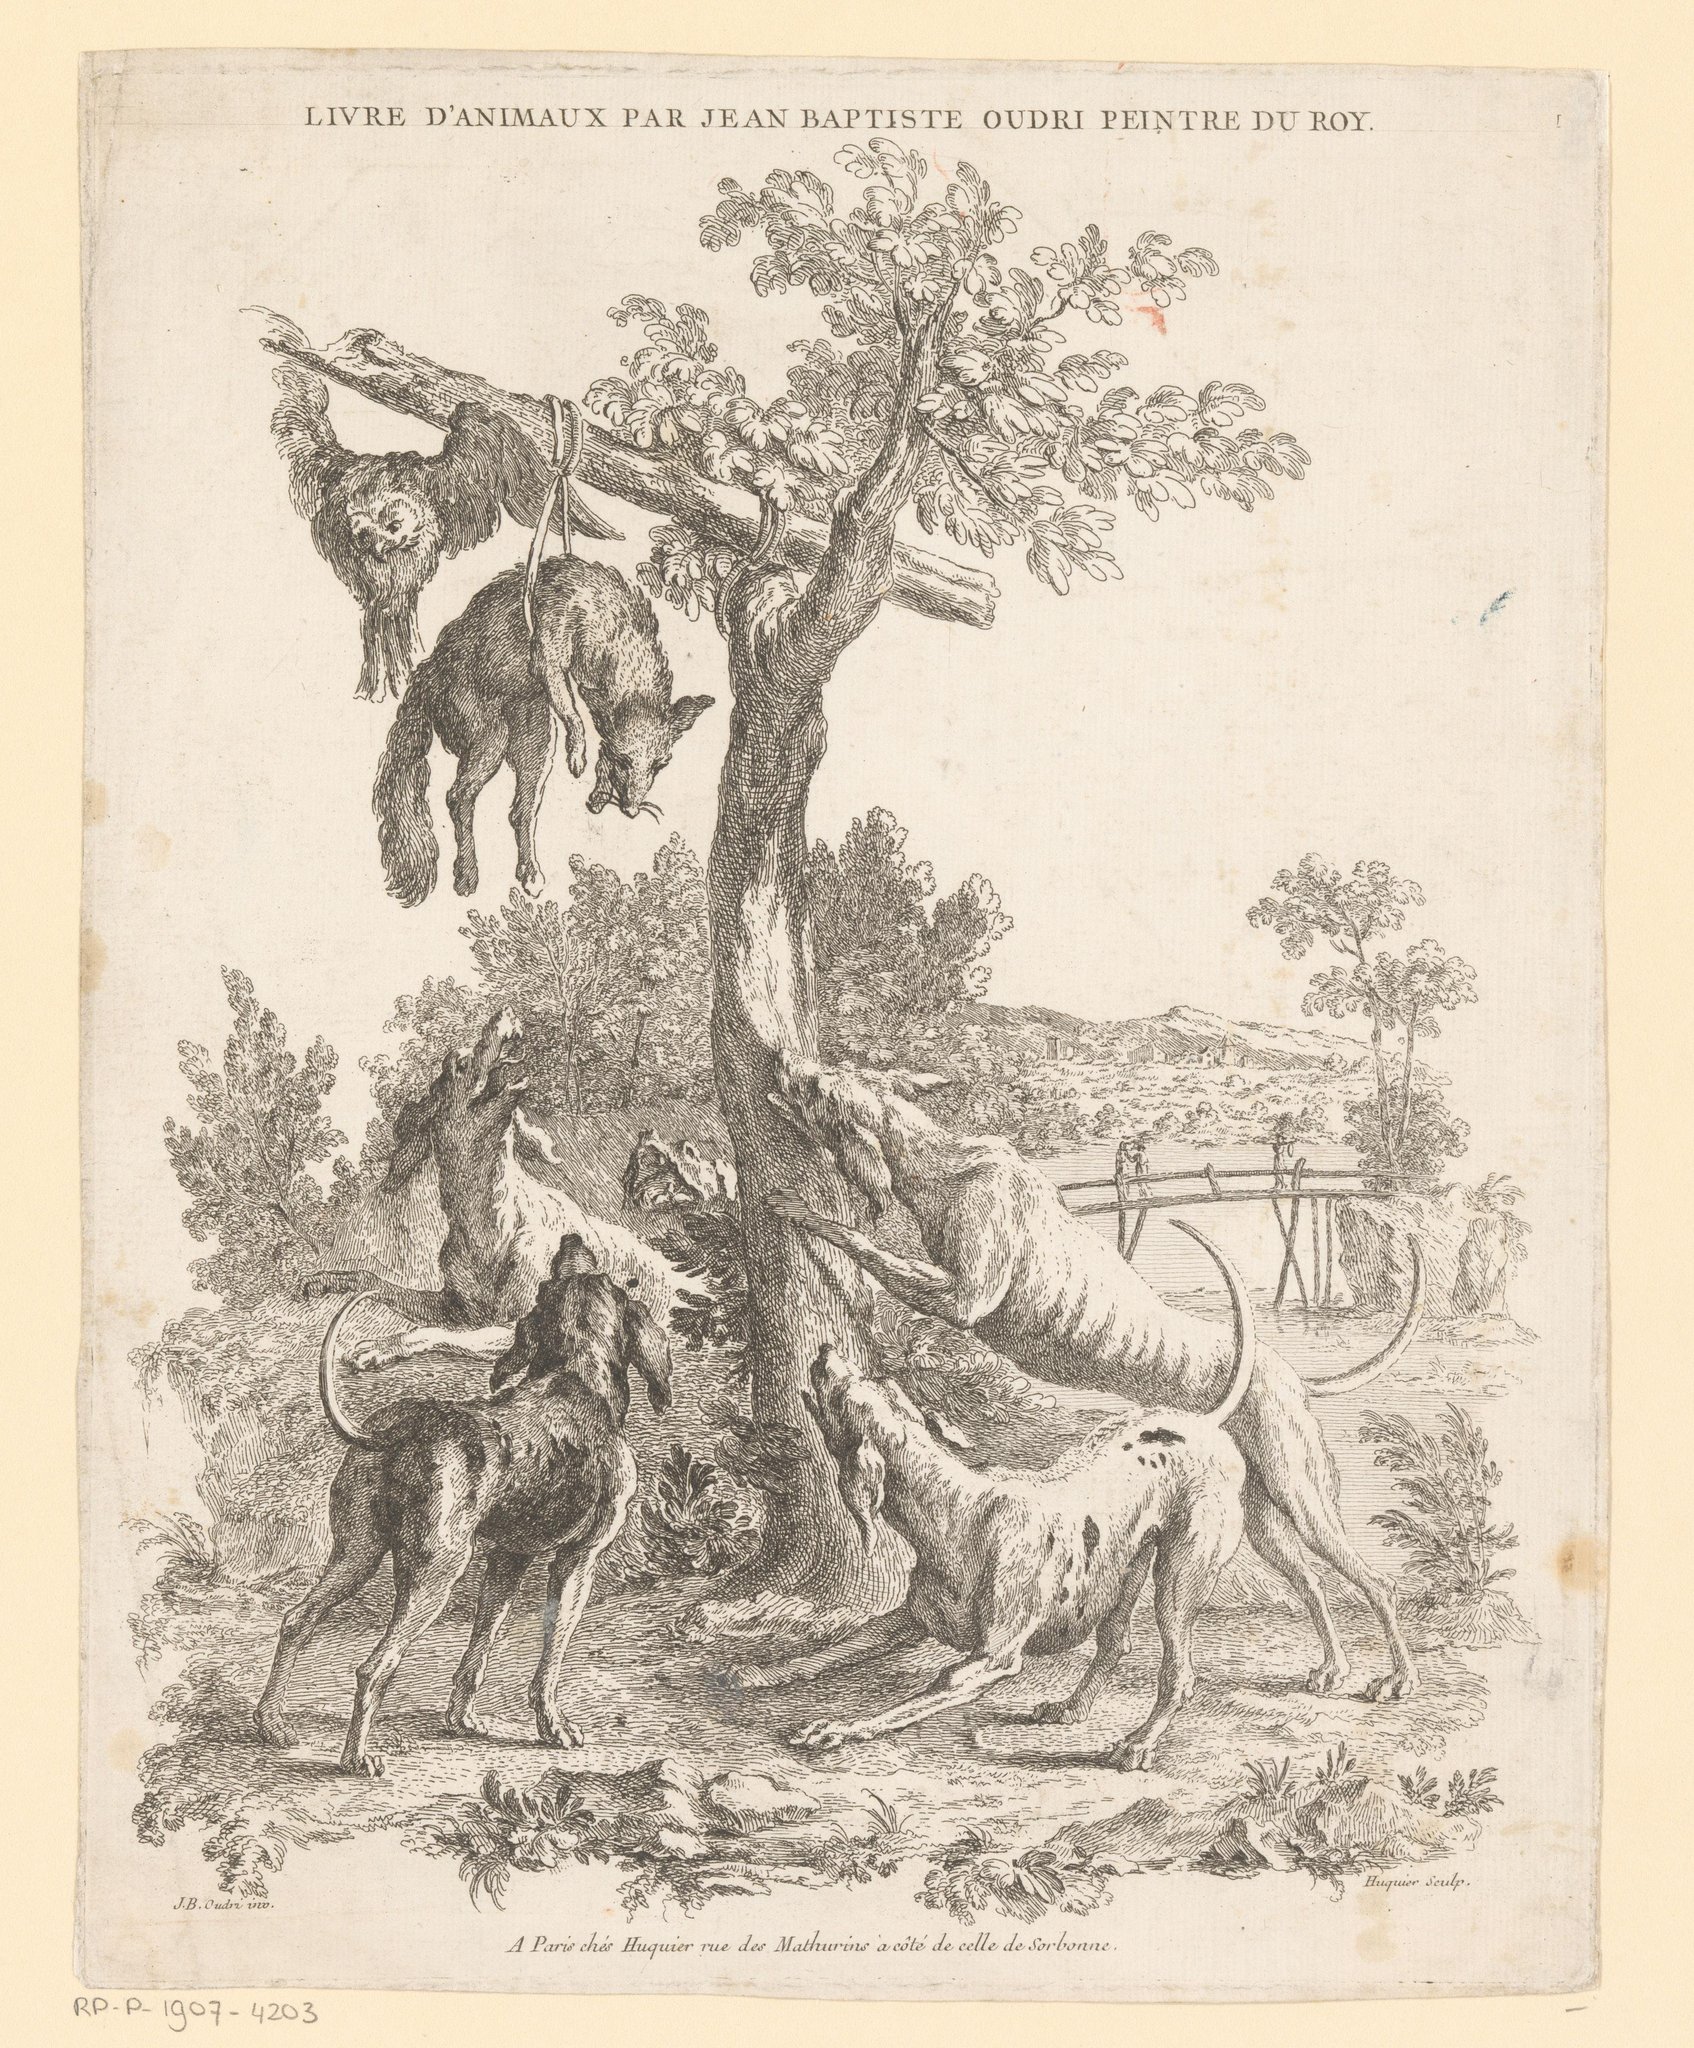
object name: print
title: Livre D'Animaux Par Jean Baptiste Oudri Peintre Du Roy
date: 1749-1761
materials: paper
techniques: etching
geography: paris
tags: fox and hounds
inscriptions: collector's mark: Lugt 2228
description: Vier (jacht)honden rond een boom springen op naar een uil en een vastgebonden dier (mogelijk een vos) boven hen.